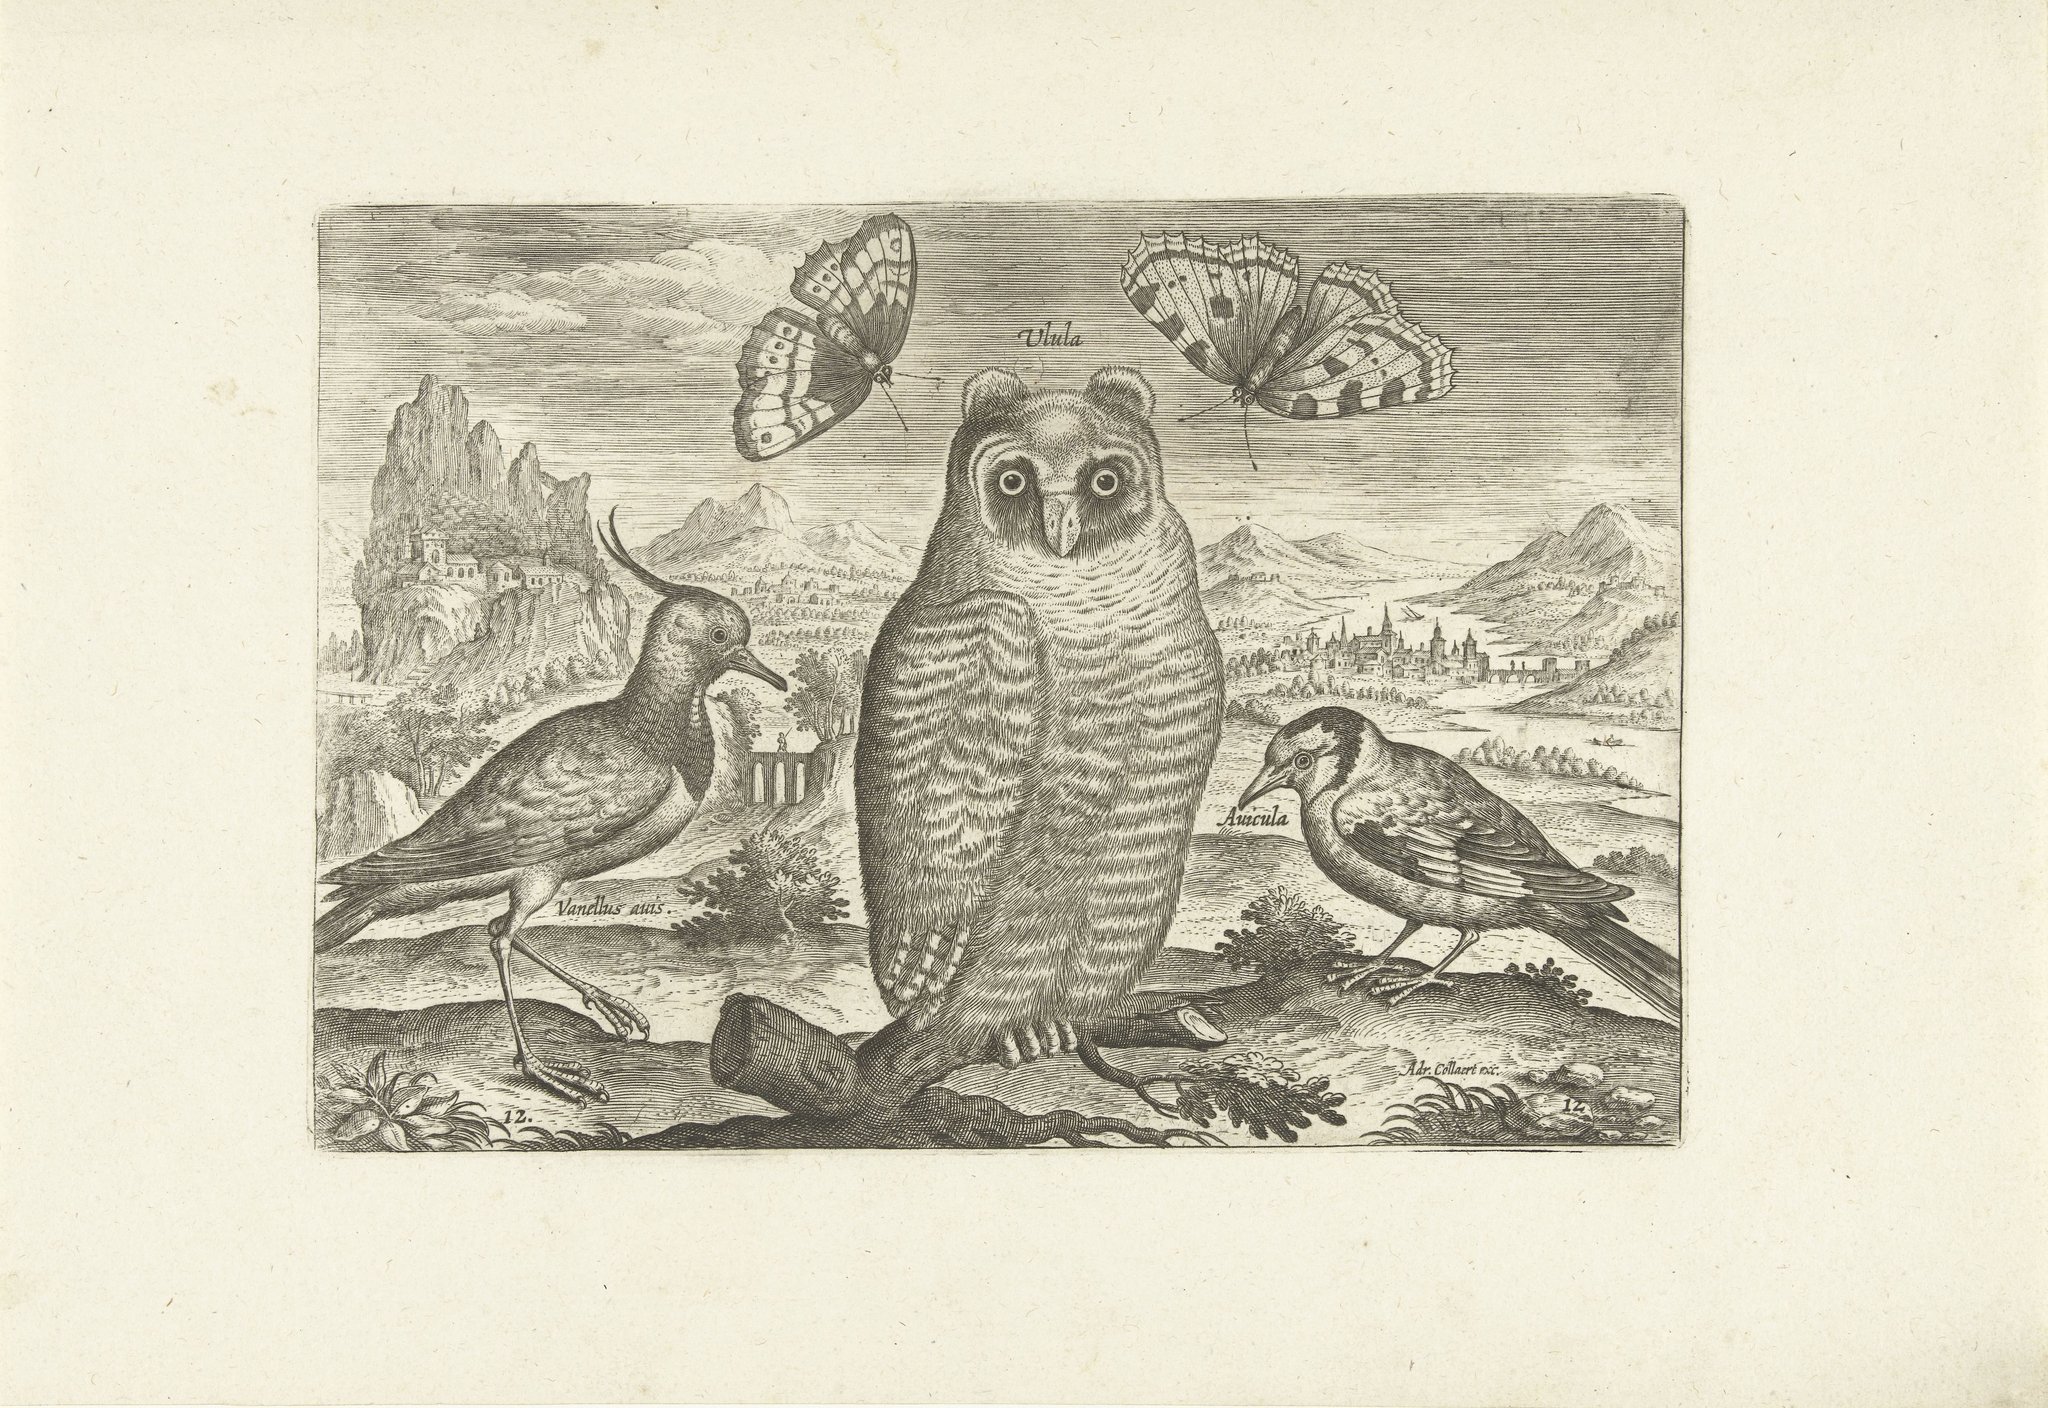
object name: print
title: Vogels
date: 1598-1618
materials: paper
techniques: engraving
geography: antwerp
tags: owls, shore-birds and wading-birds: lapwing, insects: butterfly, song-birds: finch, landscapes (+ landscape with figures, staffage)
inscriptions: collector's mark: Lugt 2228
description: Een uil, een goudvink en een kievit op de voorgrond. Boven hen vliegen twee vlinders. Op de achtergrond een landschap. De prent maakt deel uit van een serie met vogels als onderwerp.